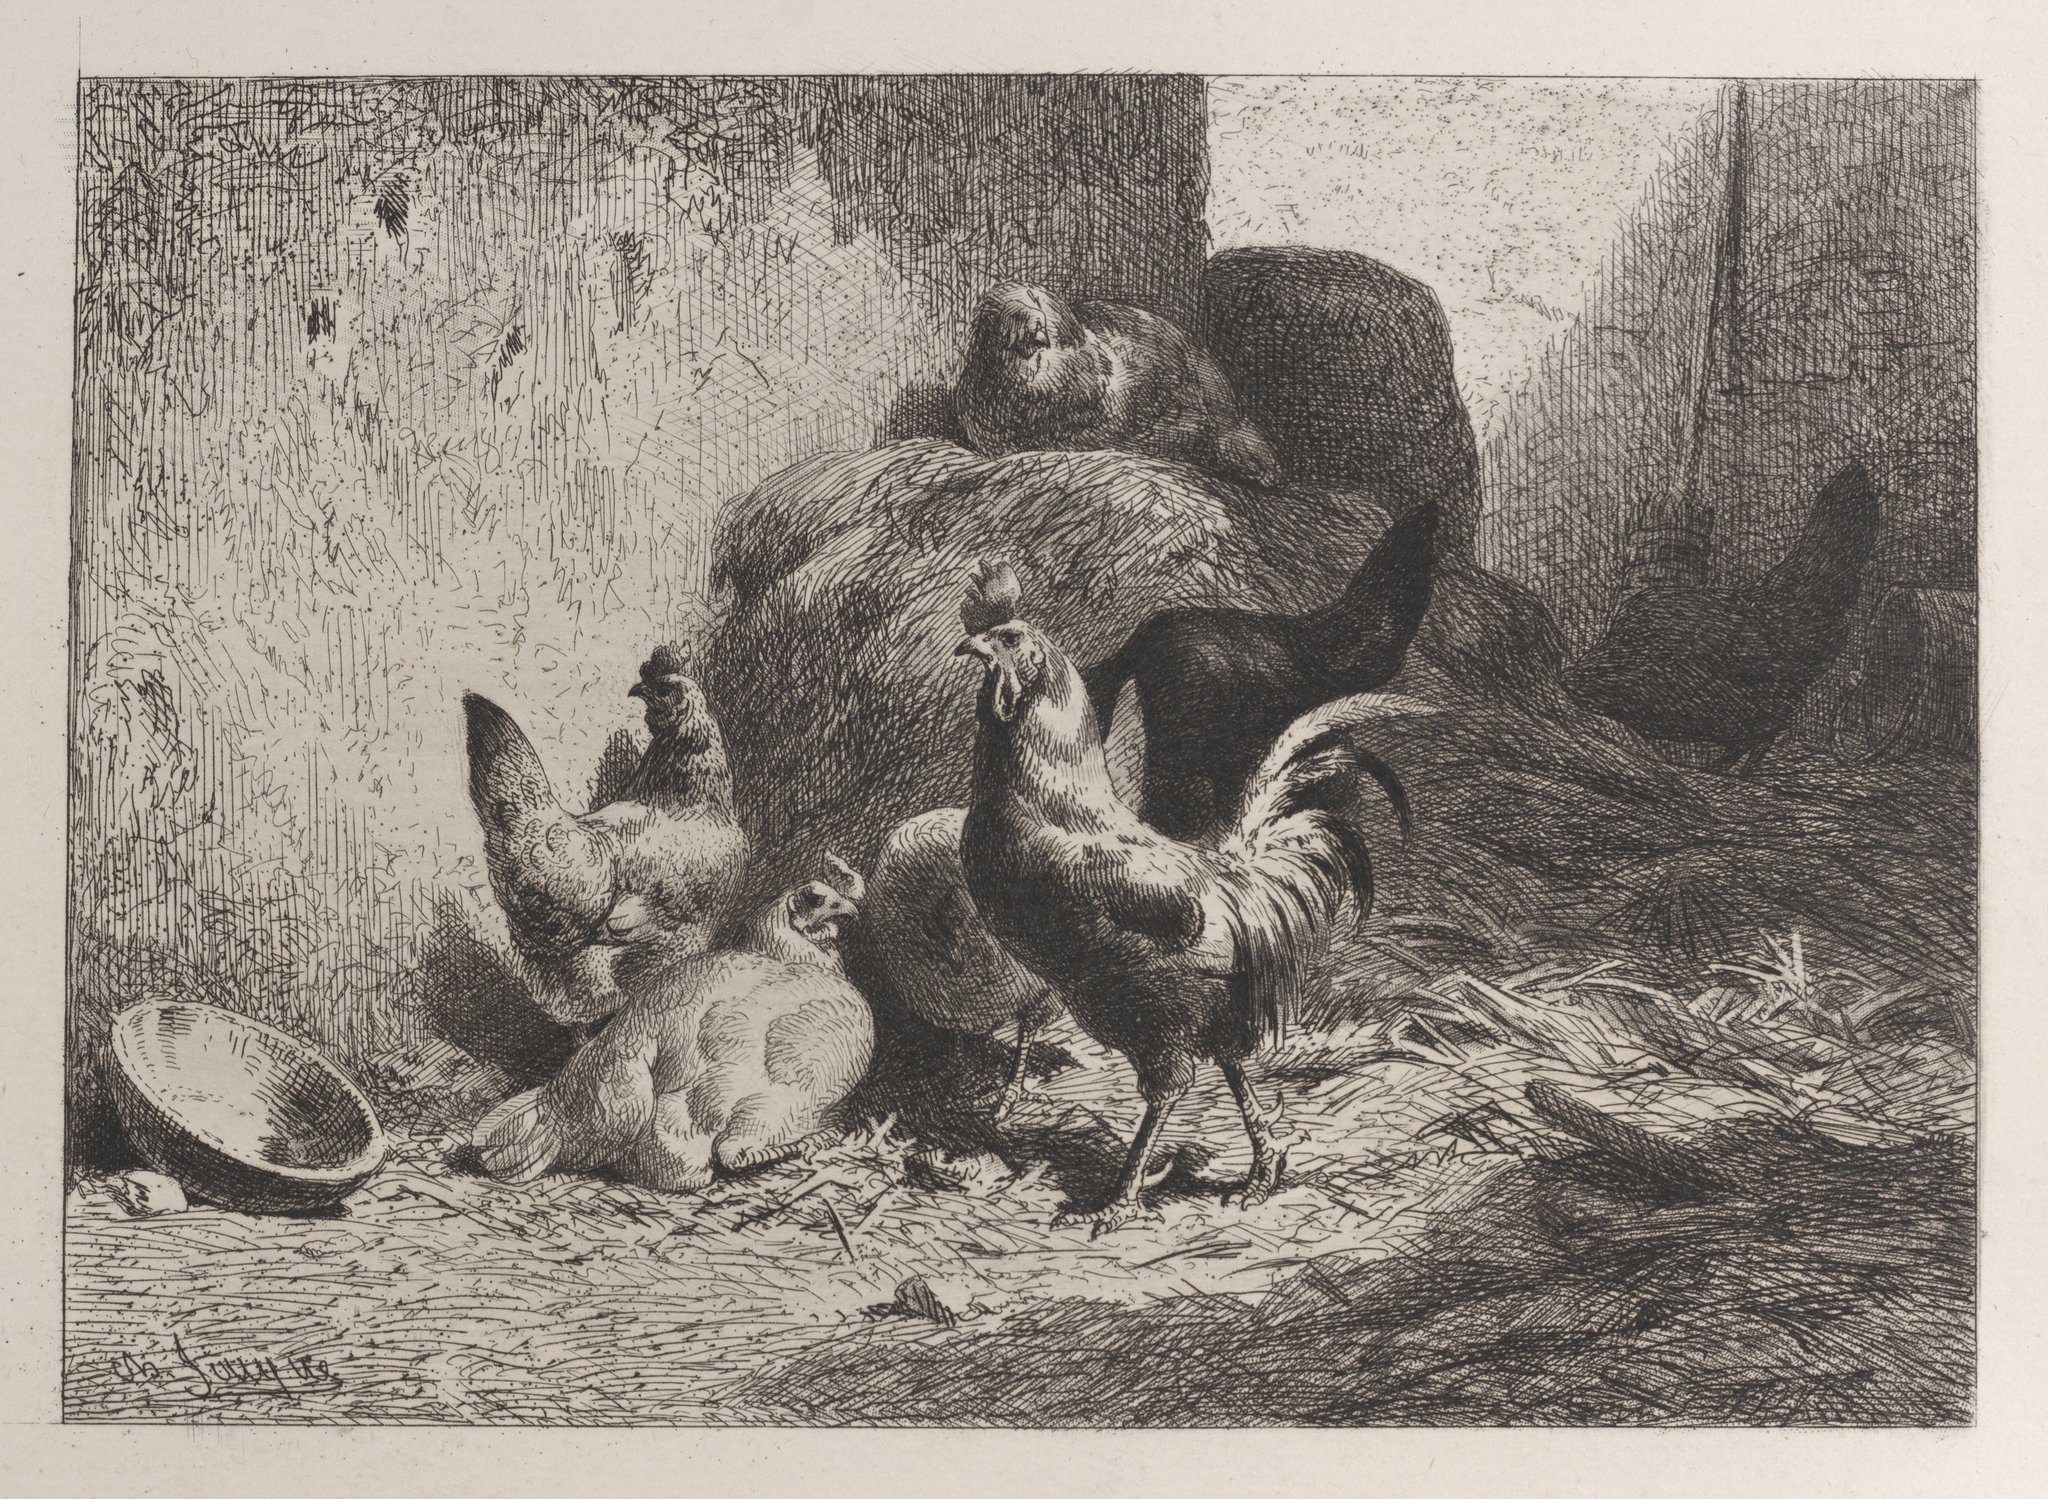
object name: print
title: Rooster and Hens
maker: charles émile jacque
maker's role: artist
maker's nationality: french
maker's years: 1813-1894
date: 1864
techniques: etching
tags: roosters